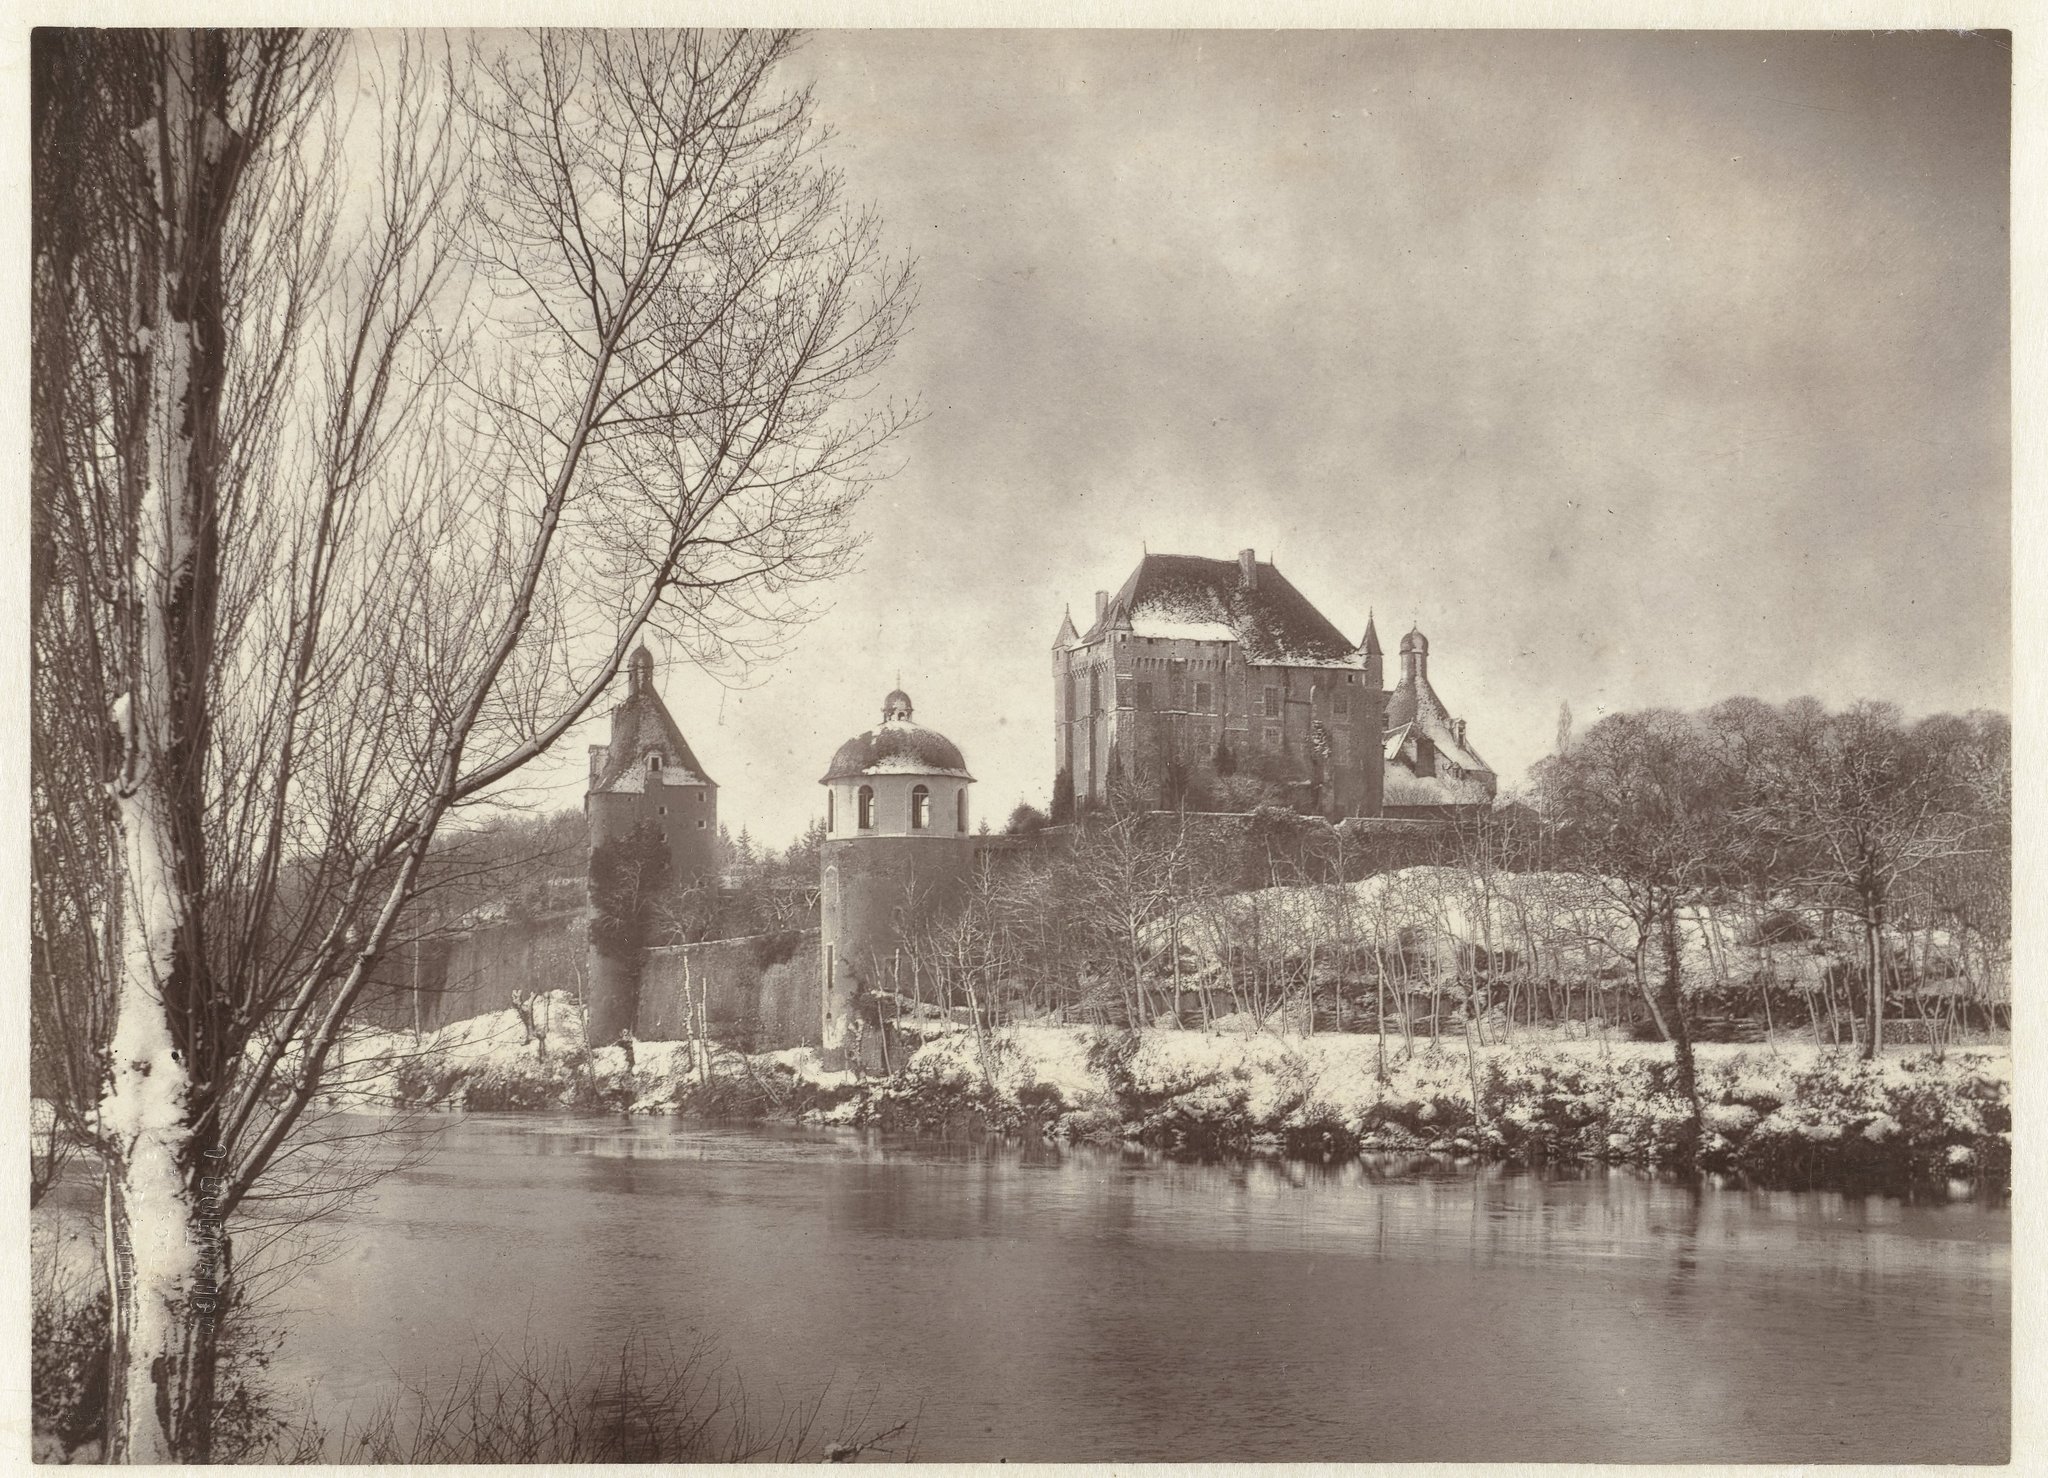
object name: photomechanical print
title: Bonnes, Château de Touffou (Vienne)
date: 1880-1886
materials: paper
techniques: woodburytype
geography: bonnes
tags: castle